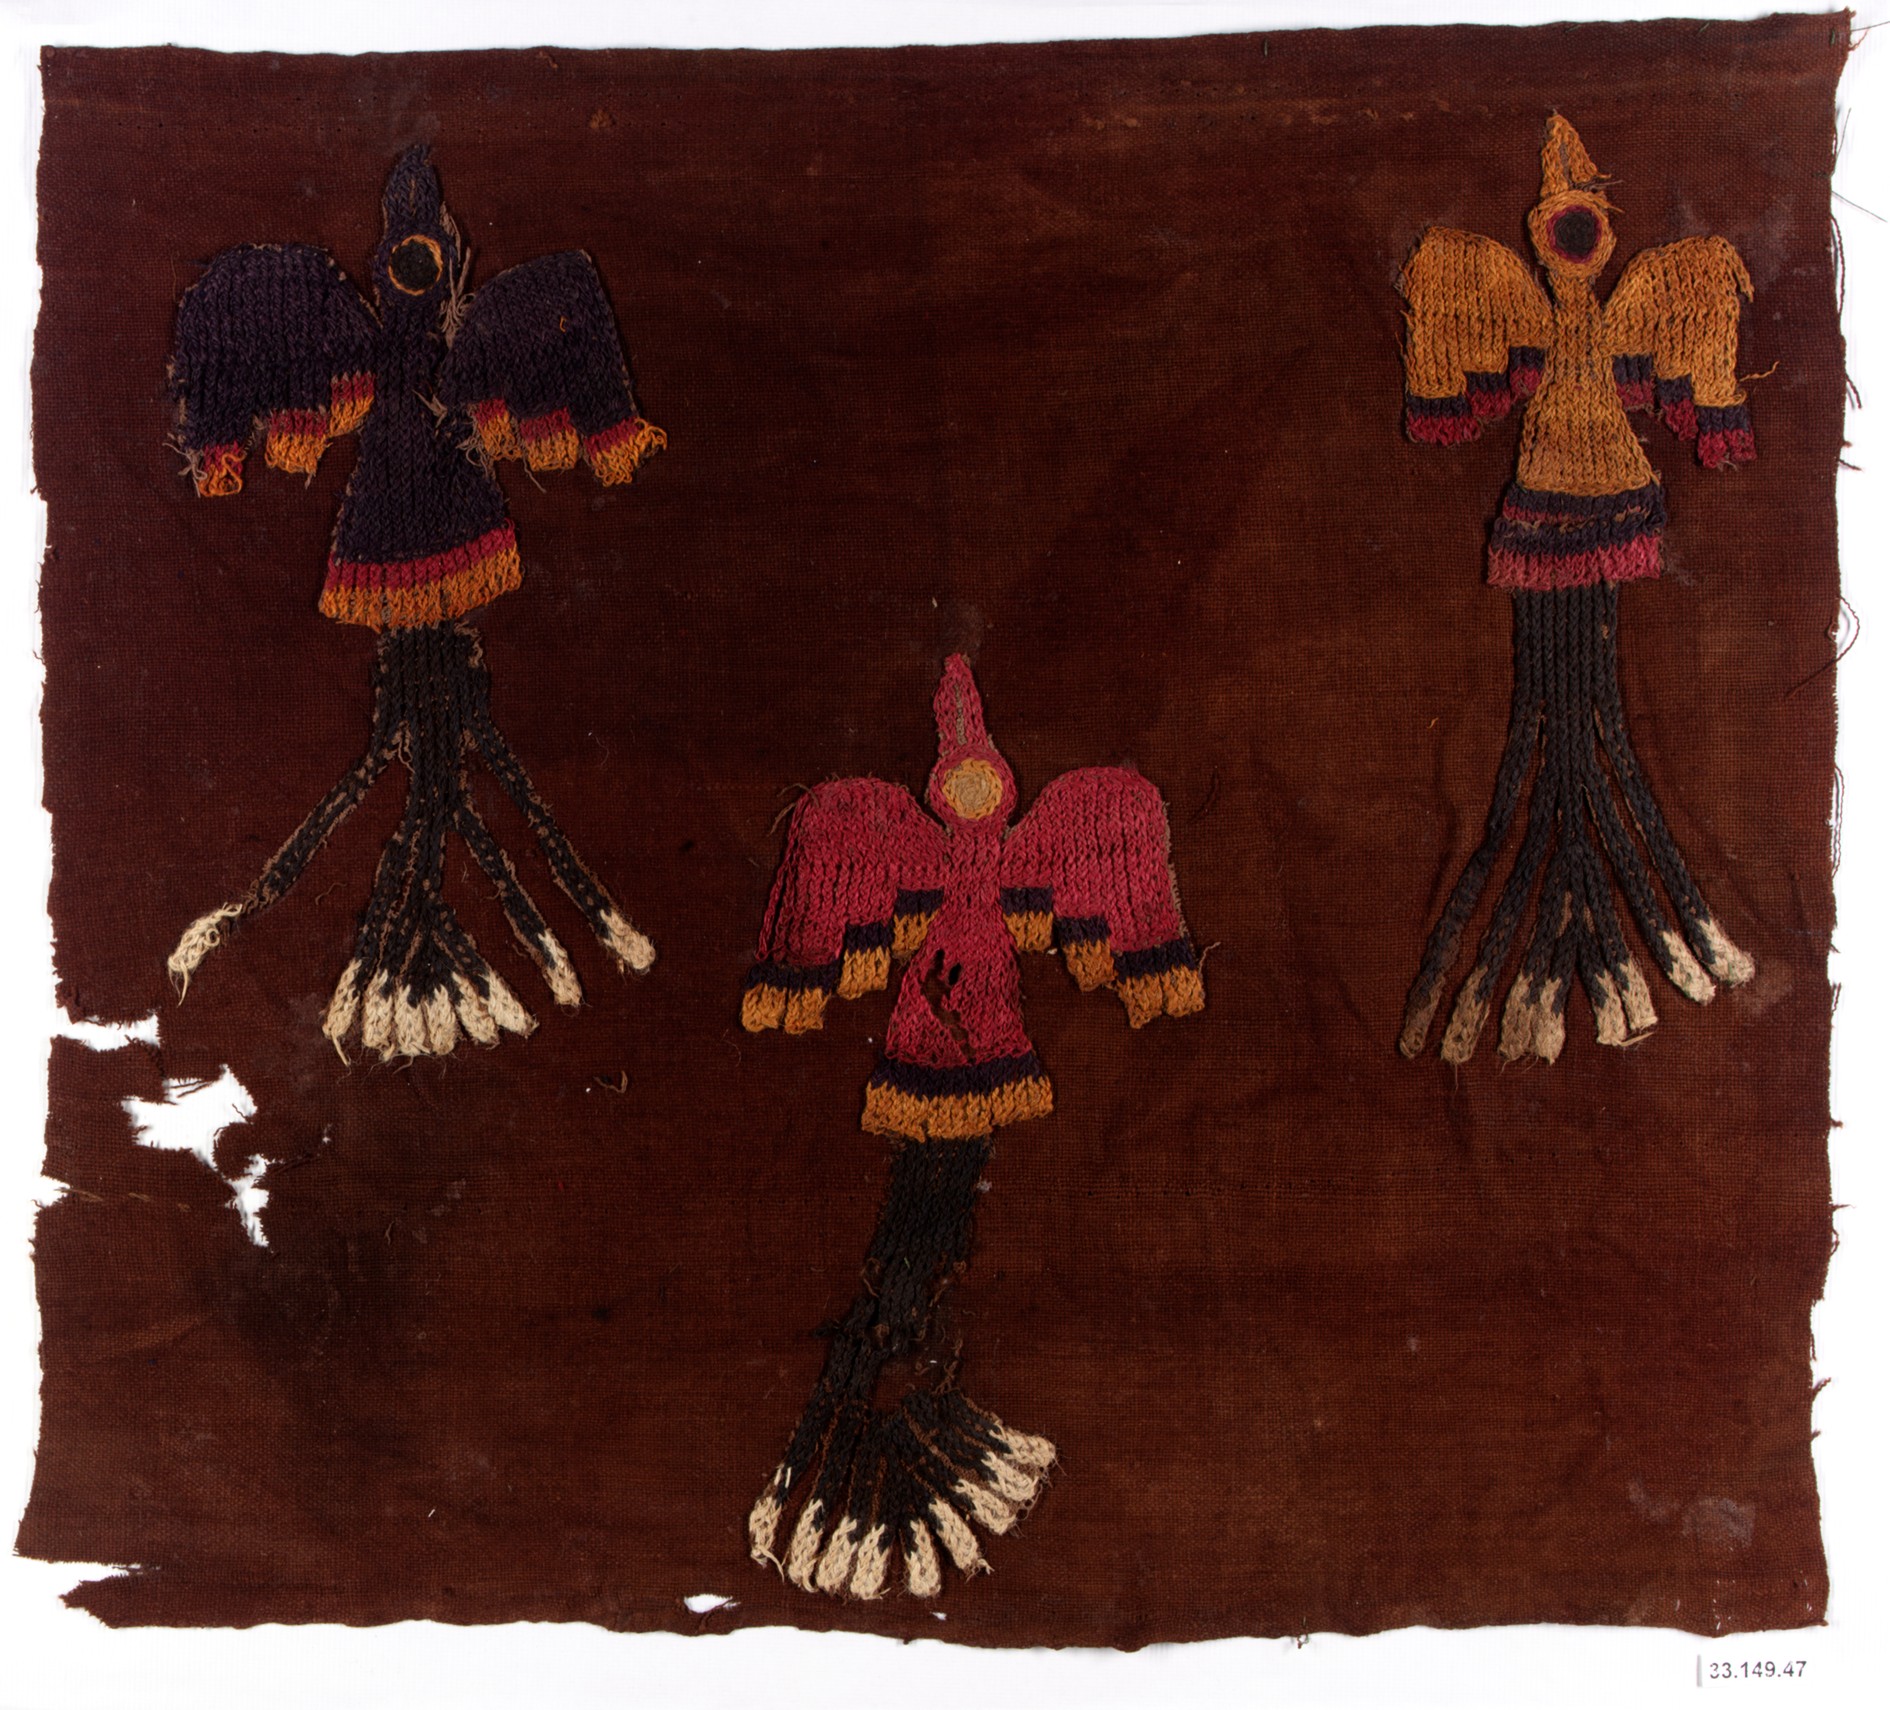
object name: textile fragment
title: Cloth Fragment with Birds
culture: peruvian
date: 901-1500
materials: animal fiber, cotton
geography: peru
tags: birds